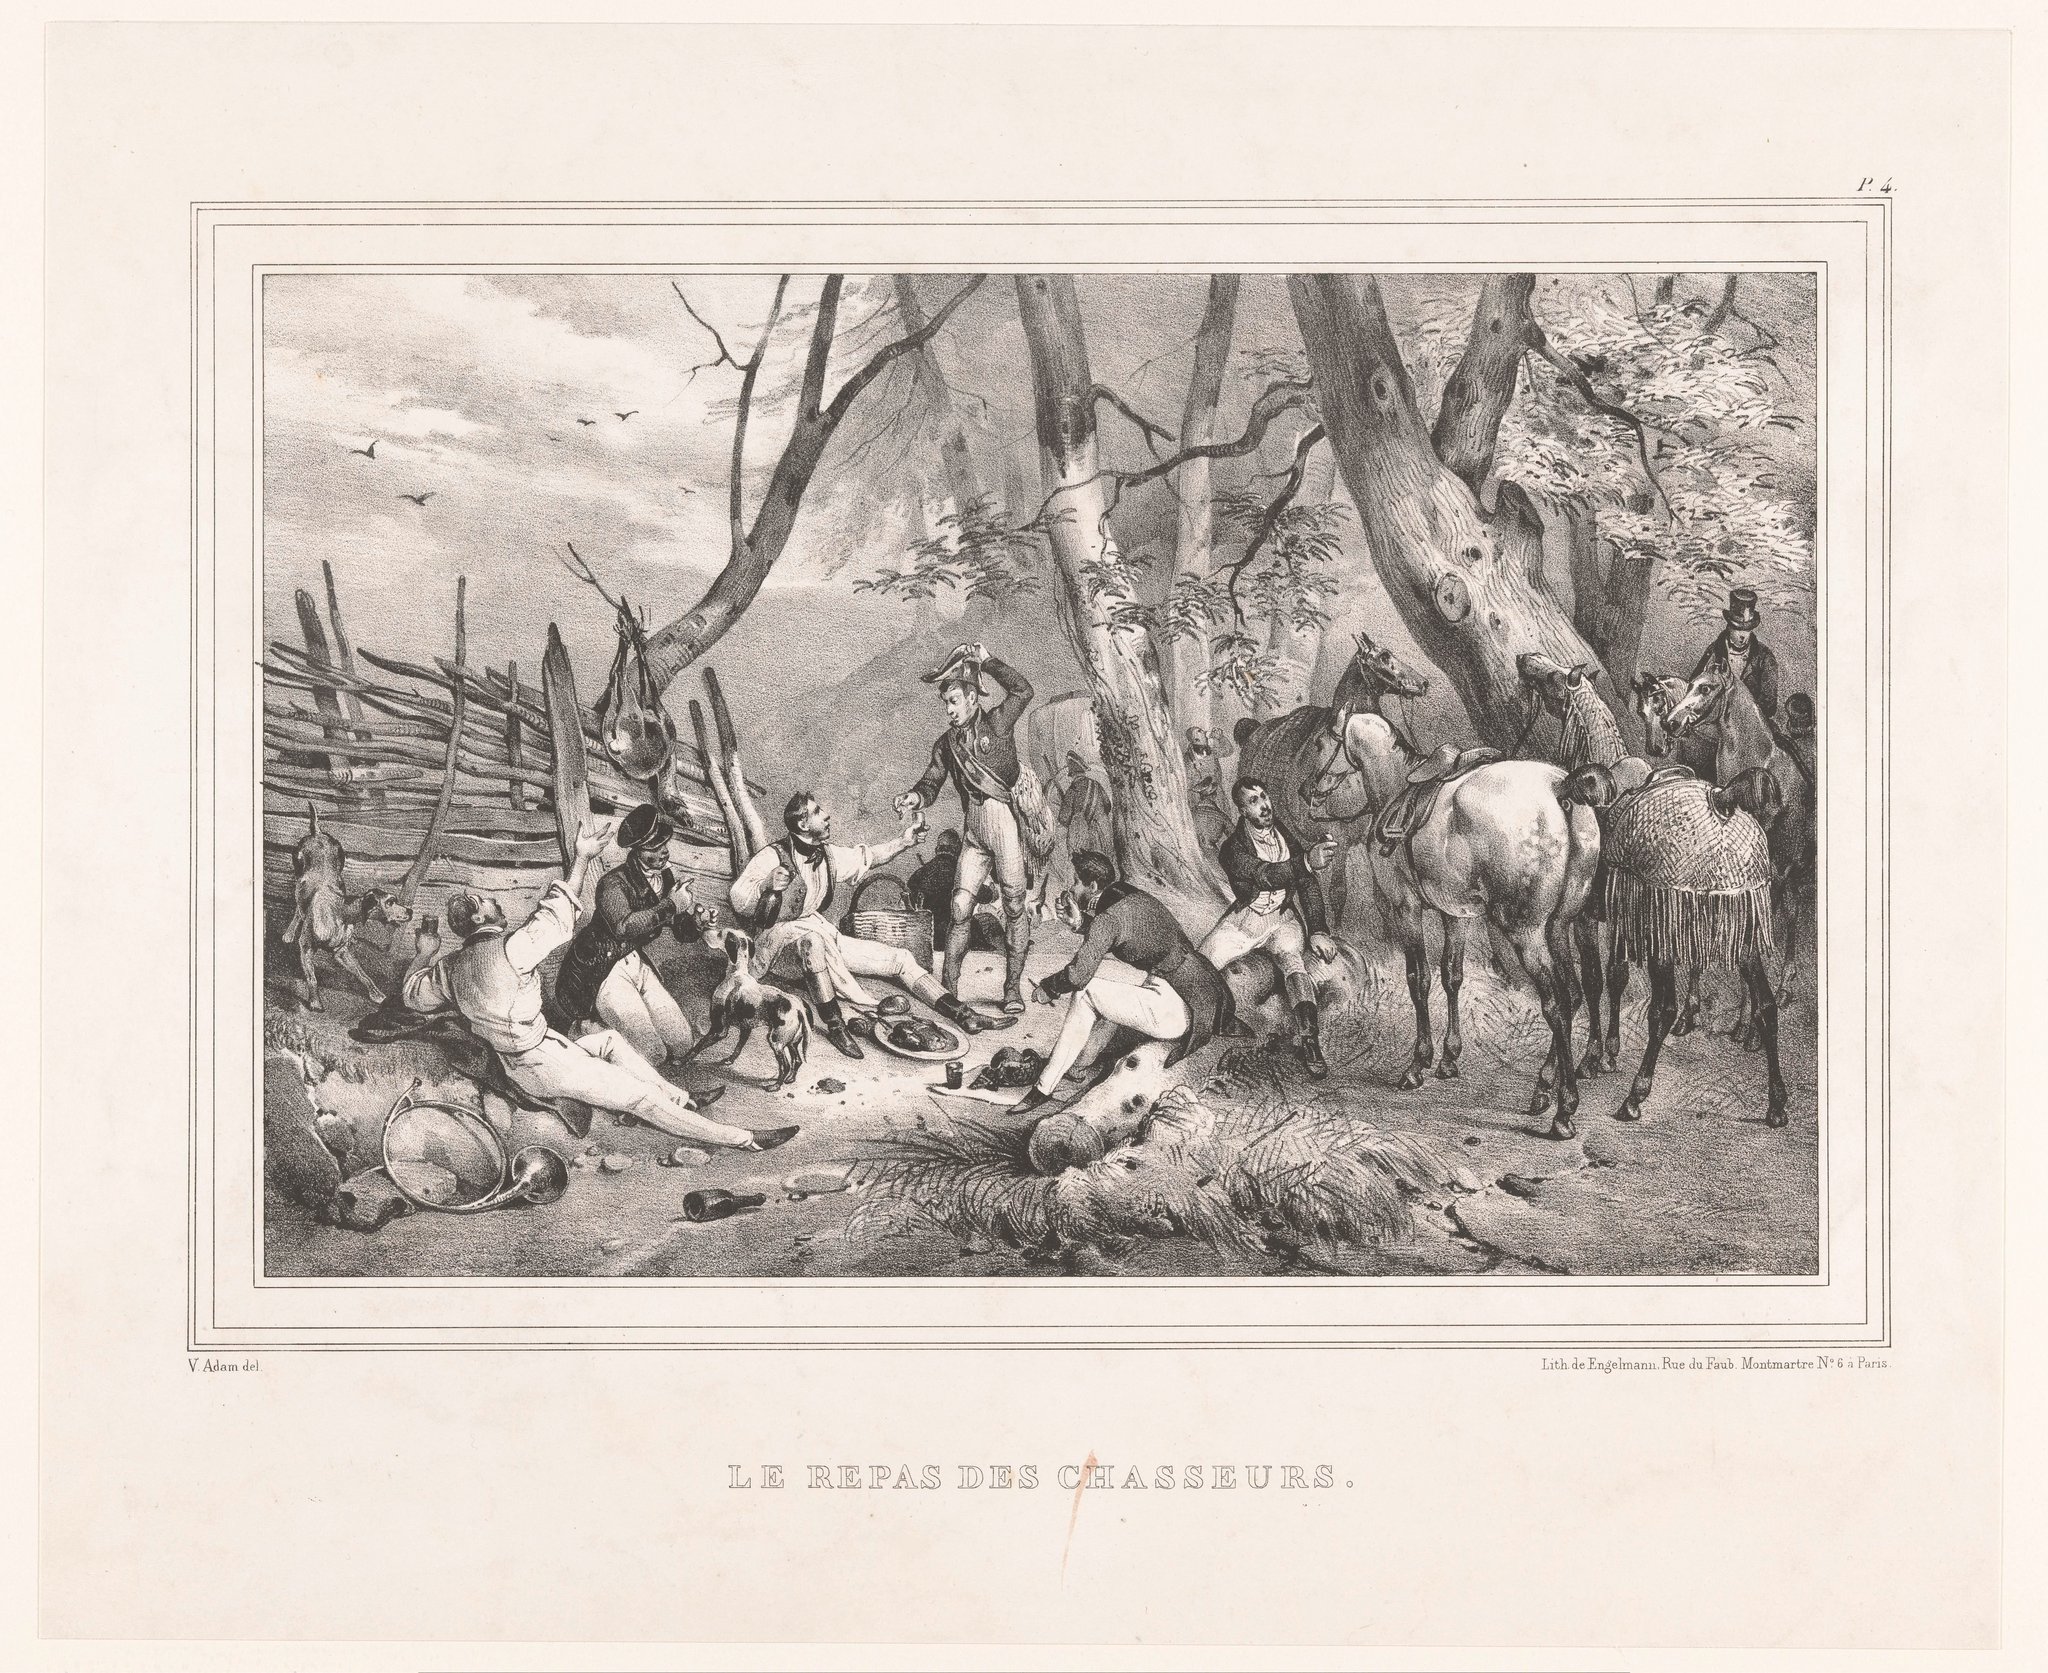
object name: print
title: Le repas des chasseurs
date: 1829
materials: paper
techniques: lithograph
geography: paris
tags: hunters resting during the hunt - cc - female hunter, huntress, horse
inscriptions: collector's mark: Lugt 2228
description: Elf jagers zijn van hun paarden afgestegen om met elkaar te eten in het bos.